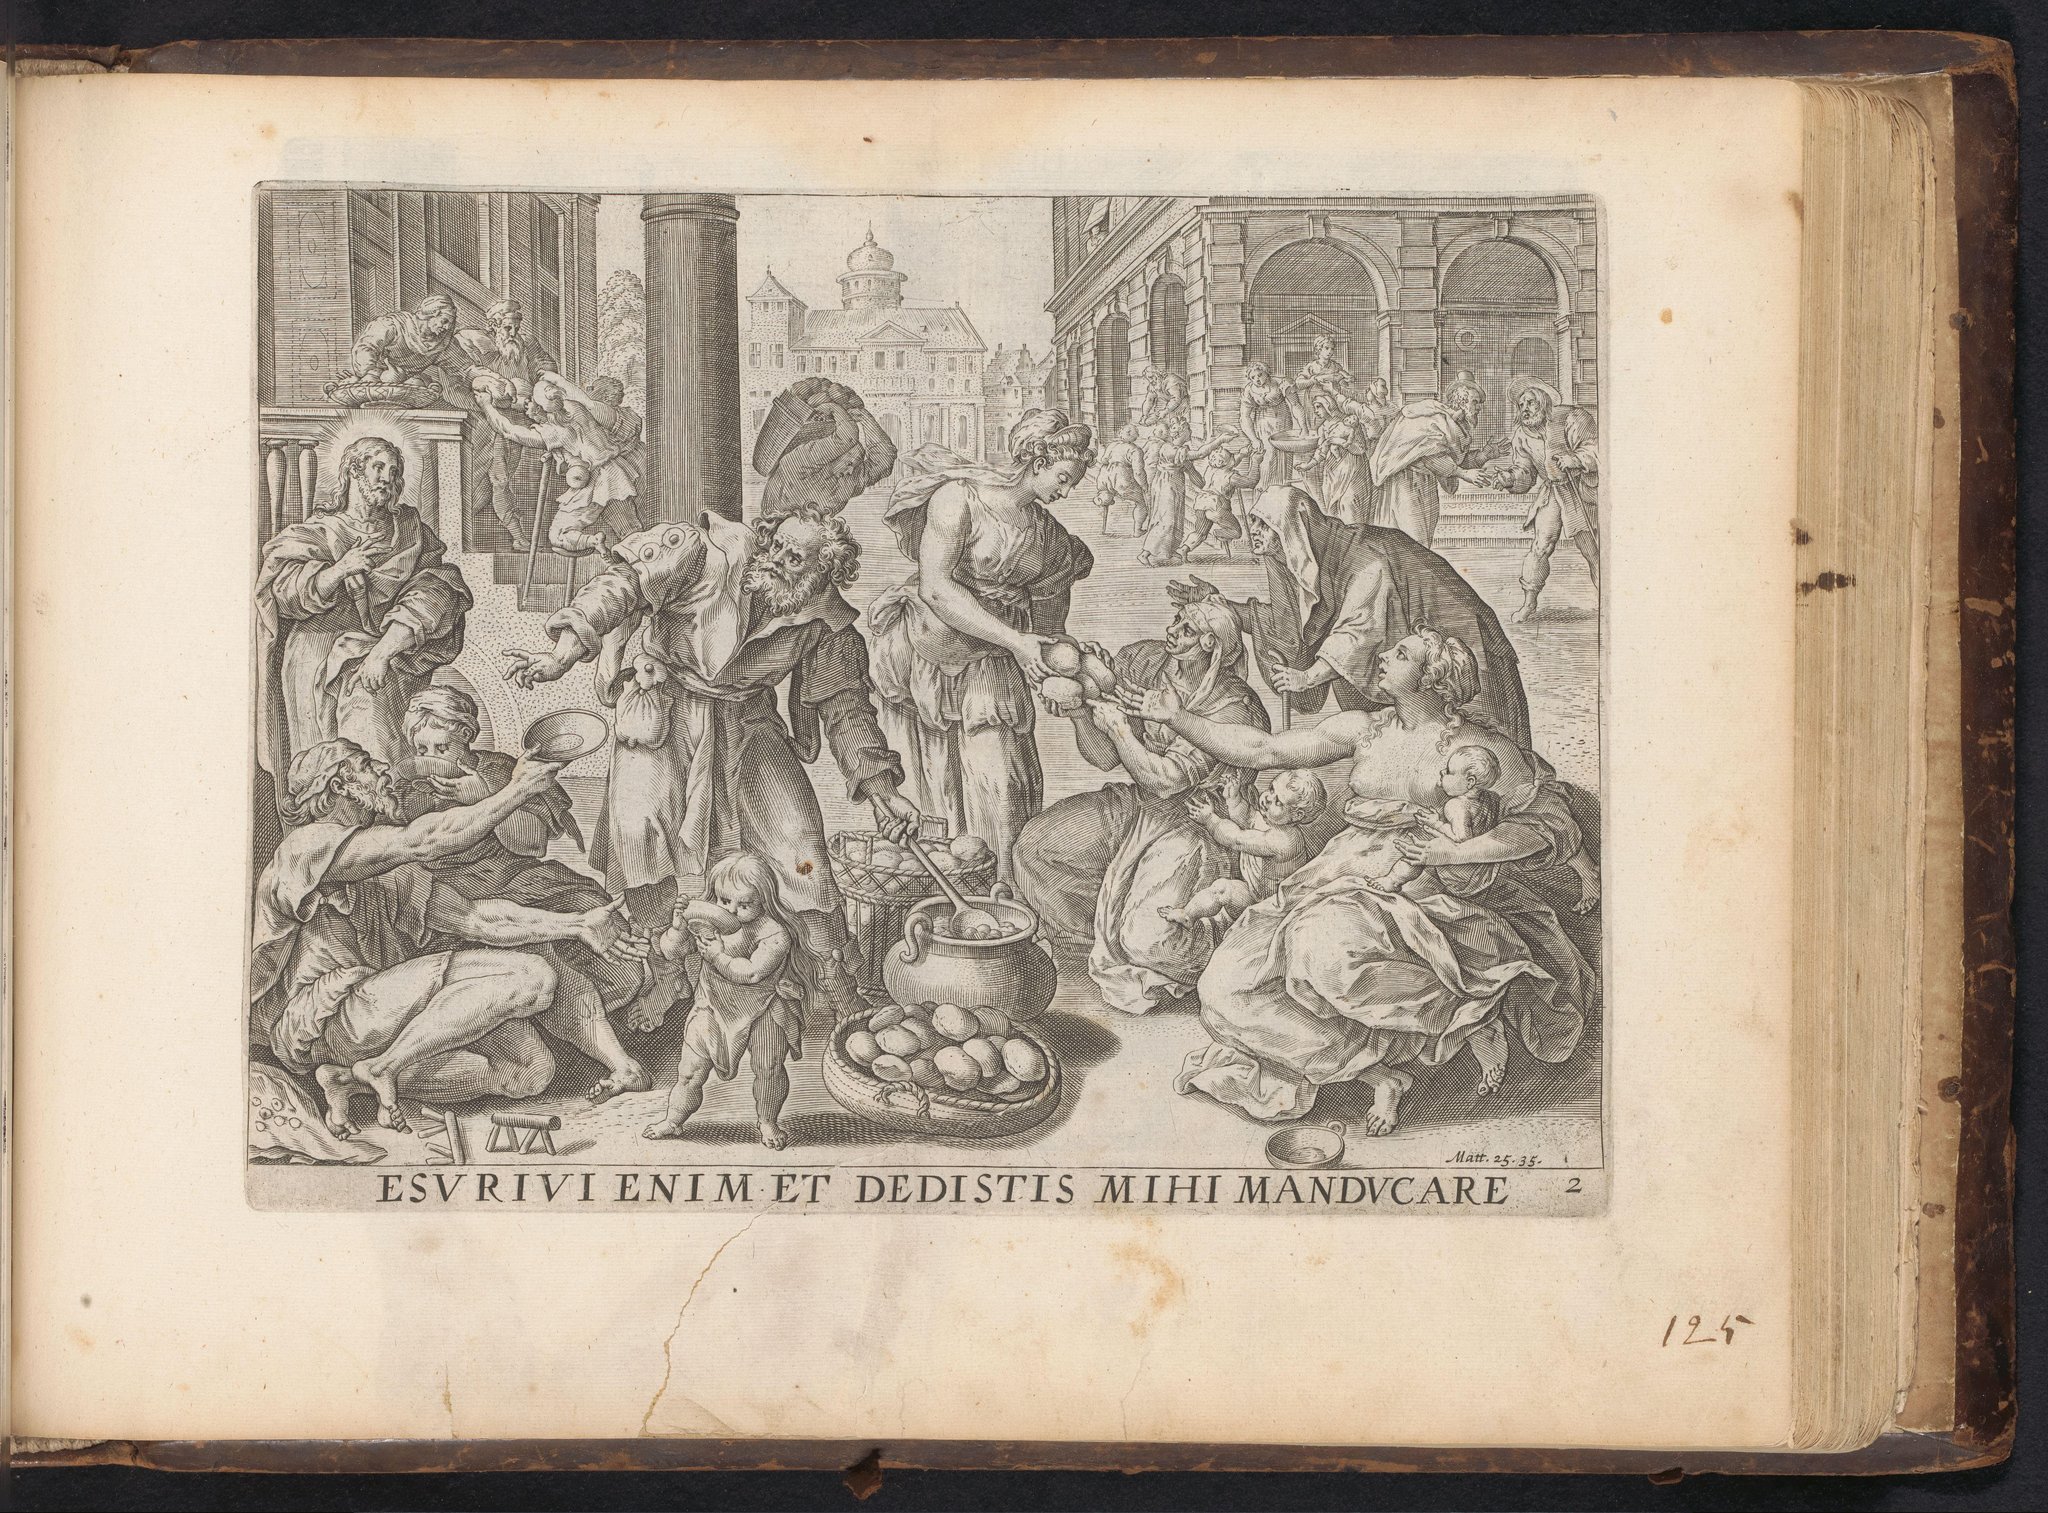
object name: print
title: Van de Wercken der Barmherticheyt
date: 1585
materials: paper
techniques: engraving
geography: amsterdam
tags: feeding the hungry, 'esuriens cibatur' ~ one of the (seven) acts of mercy - vv - christ present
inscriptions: number: ‘125’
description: Op de voorgrond delen een man en een vrouw voedsel uit aan de hongerigen. Links kijkt Christus toe. Op de achtergrond wordt eveneens voedsel uitgedeeld. Onder de voorstelling een verwijzing in het Latijn naar de Bijbeltekst in Mat. 25:35. Deze prent maakt deel uit van een album.